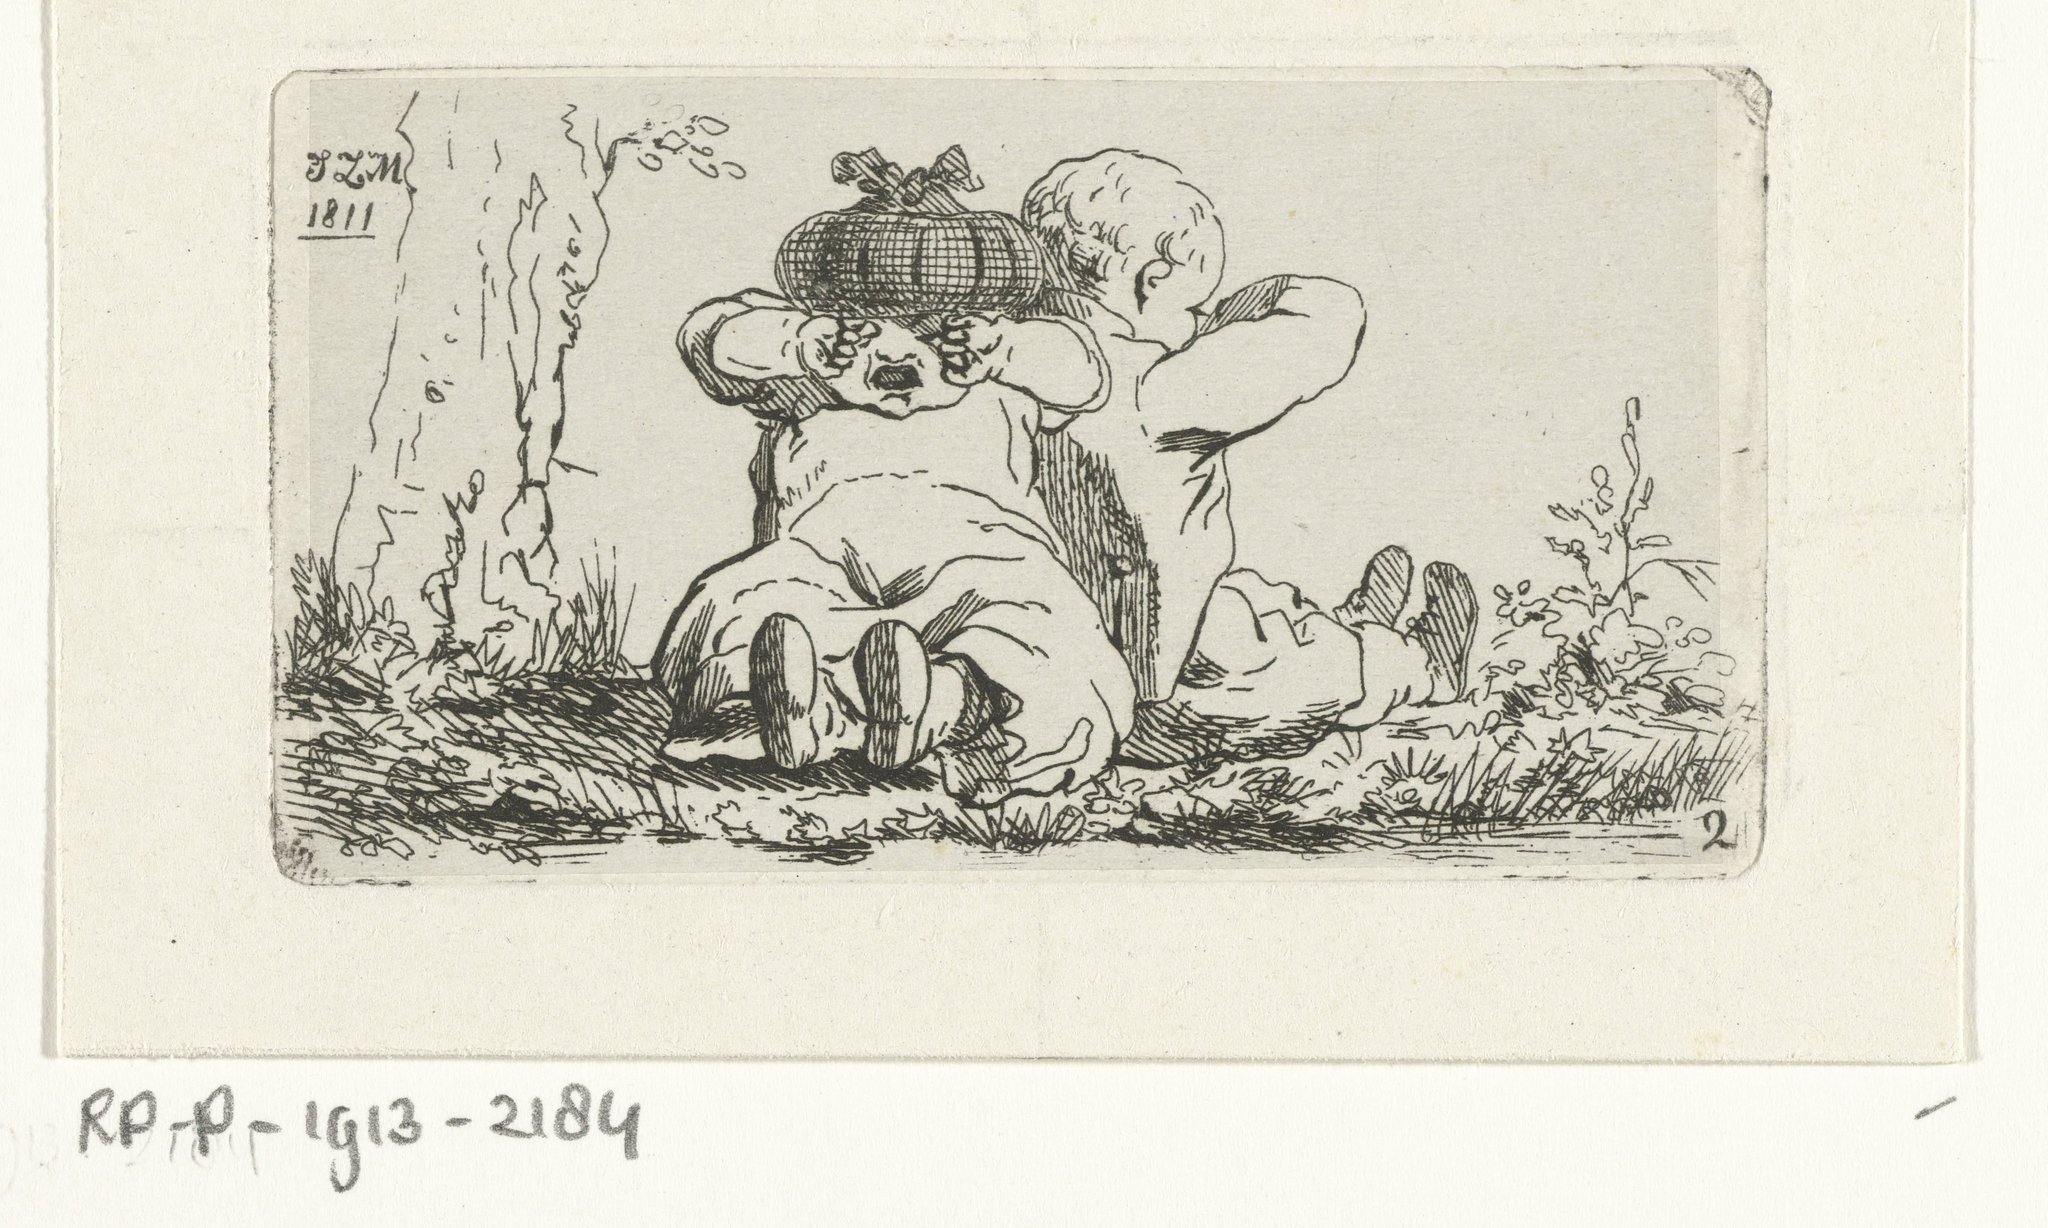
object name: print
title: Twee huilende kinderen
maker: jean zacherie mazel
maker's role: draughtsman, print maker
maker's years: 1792-1884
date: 1811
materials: paper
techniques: etching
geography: netherlands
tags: child, weeping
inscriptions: collector's mark: Lugt 2233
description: Een meisje en een jongen zitten met de rug tegen elkaar in het gras. Zij wrijven beiden in hun ogen.